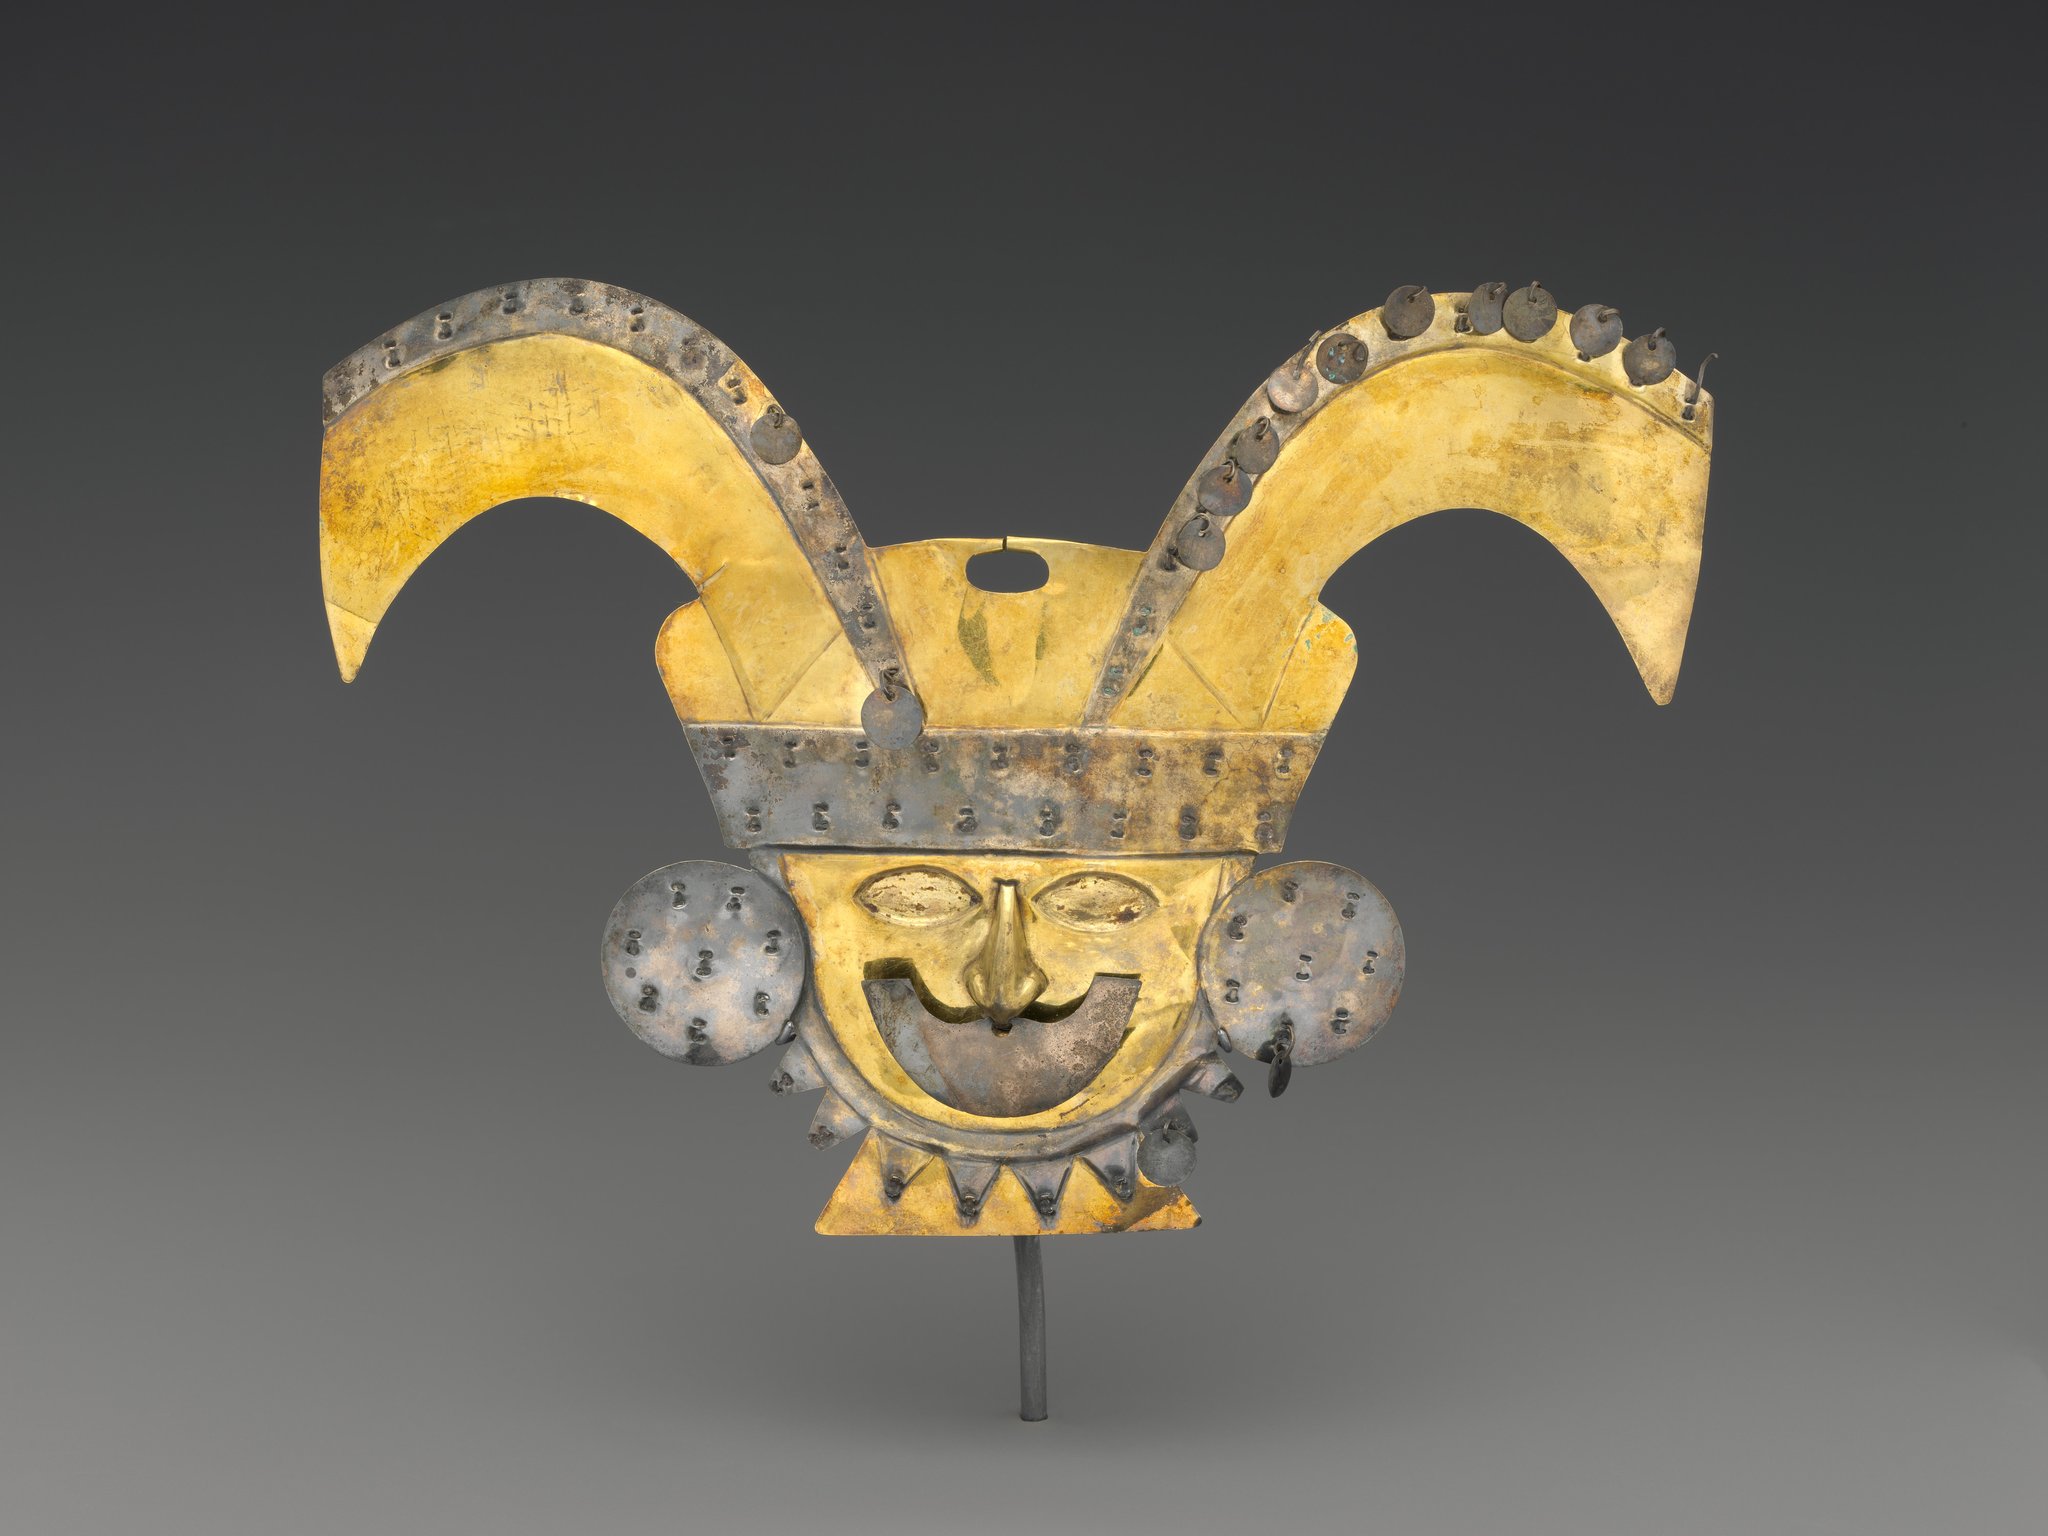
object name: ornament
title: Nose ornament in the shape of a head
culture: moche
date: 500-800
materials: gold, silver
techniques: silvered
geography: peru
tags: heads